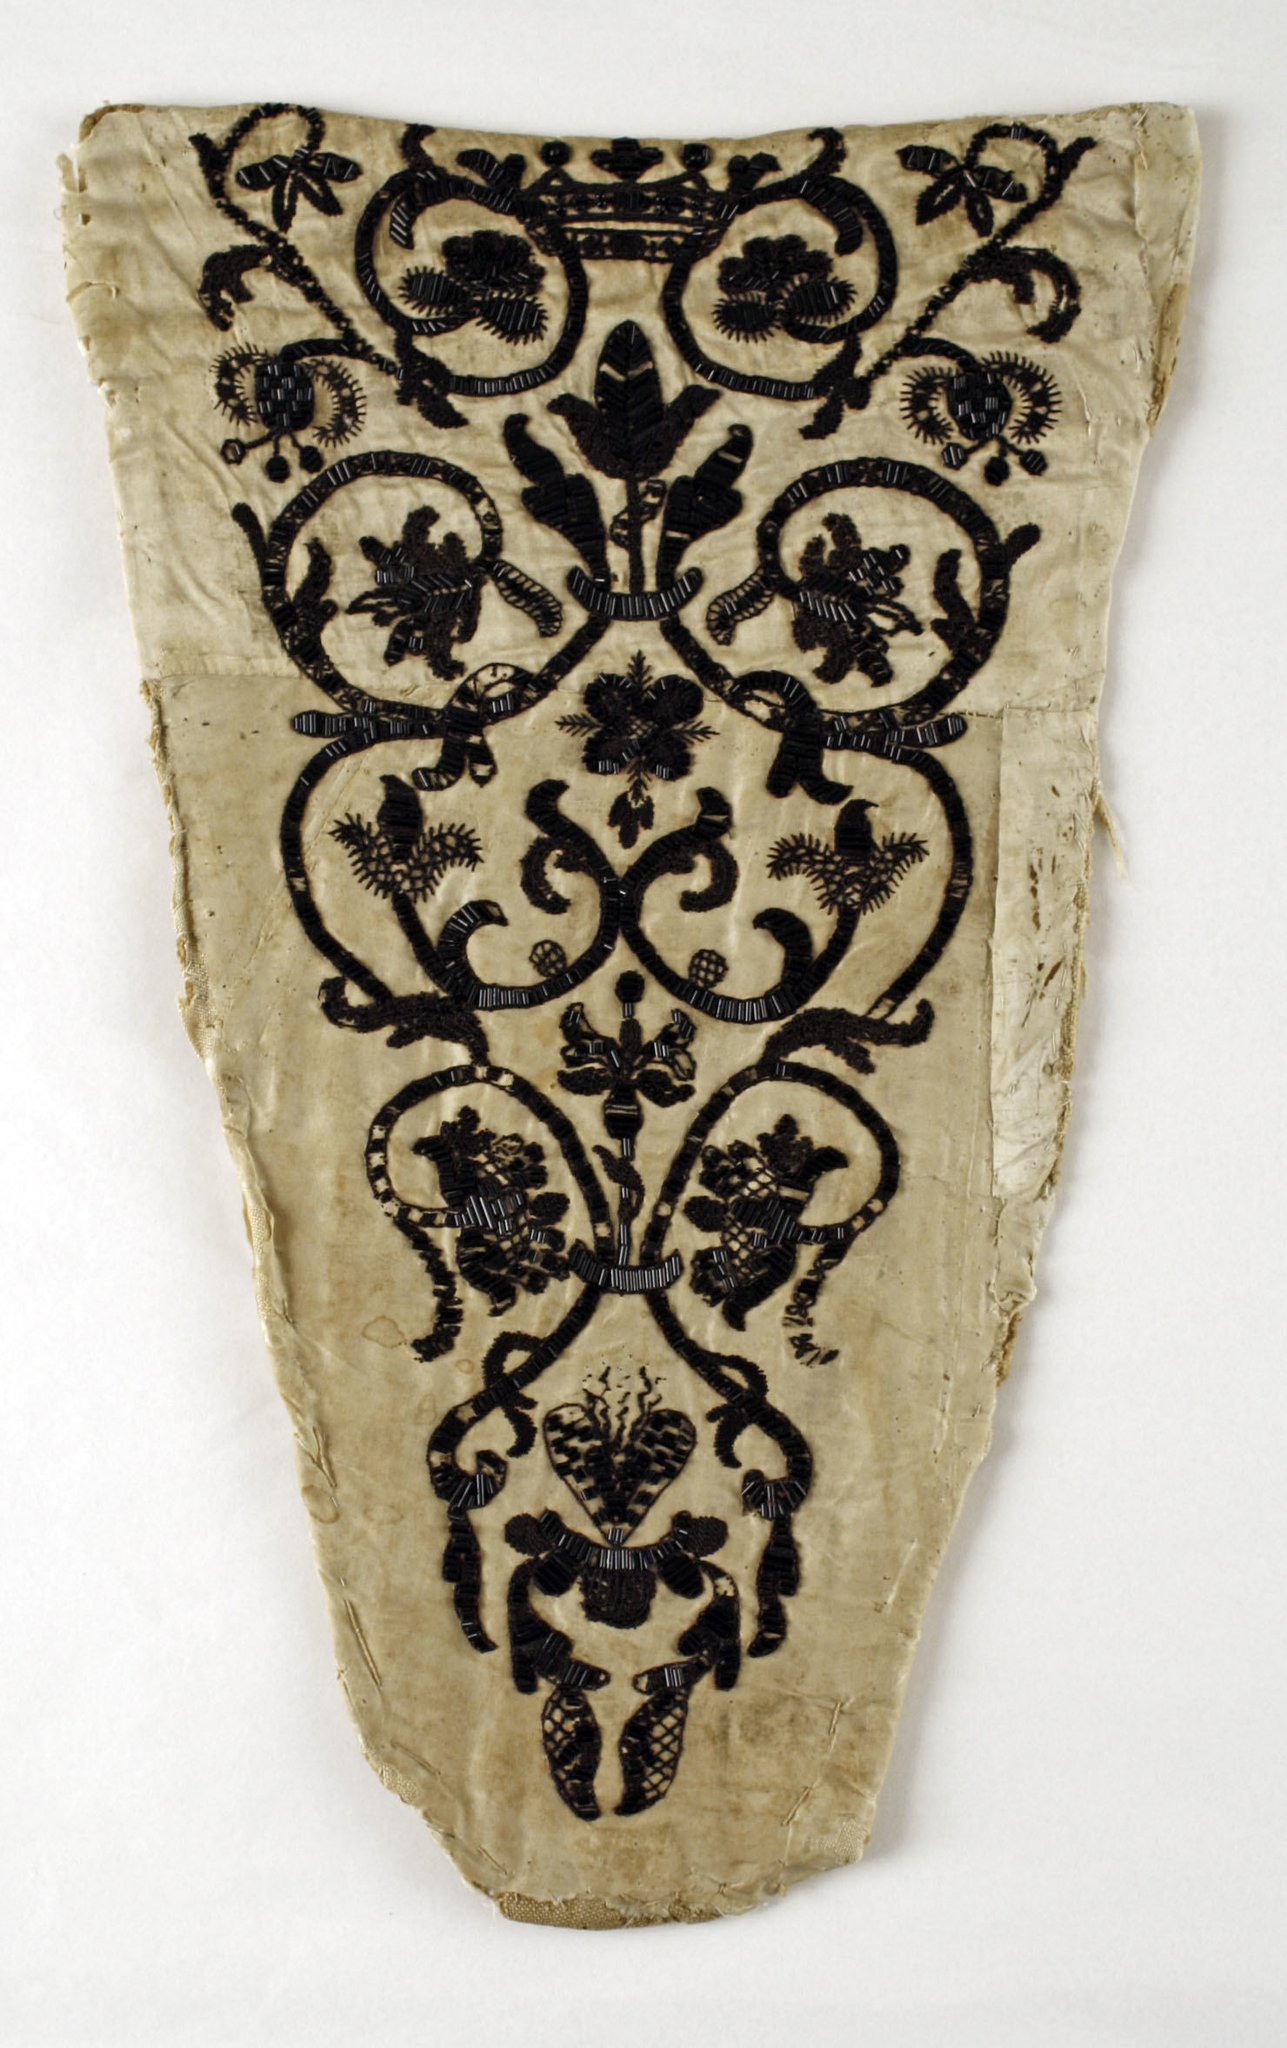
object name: stomacher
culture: italian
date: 1701-1800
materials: silk